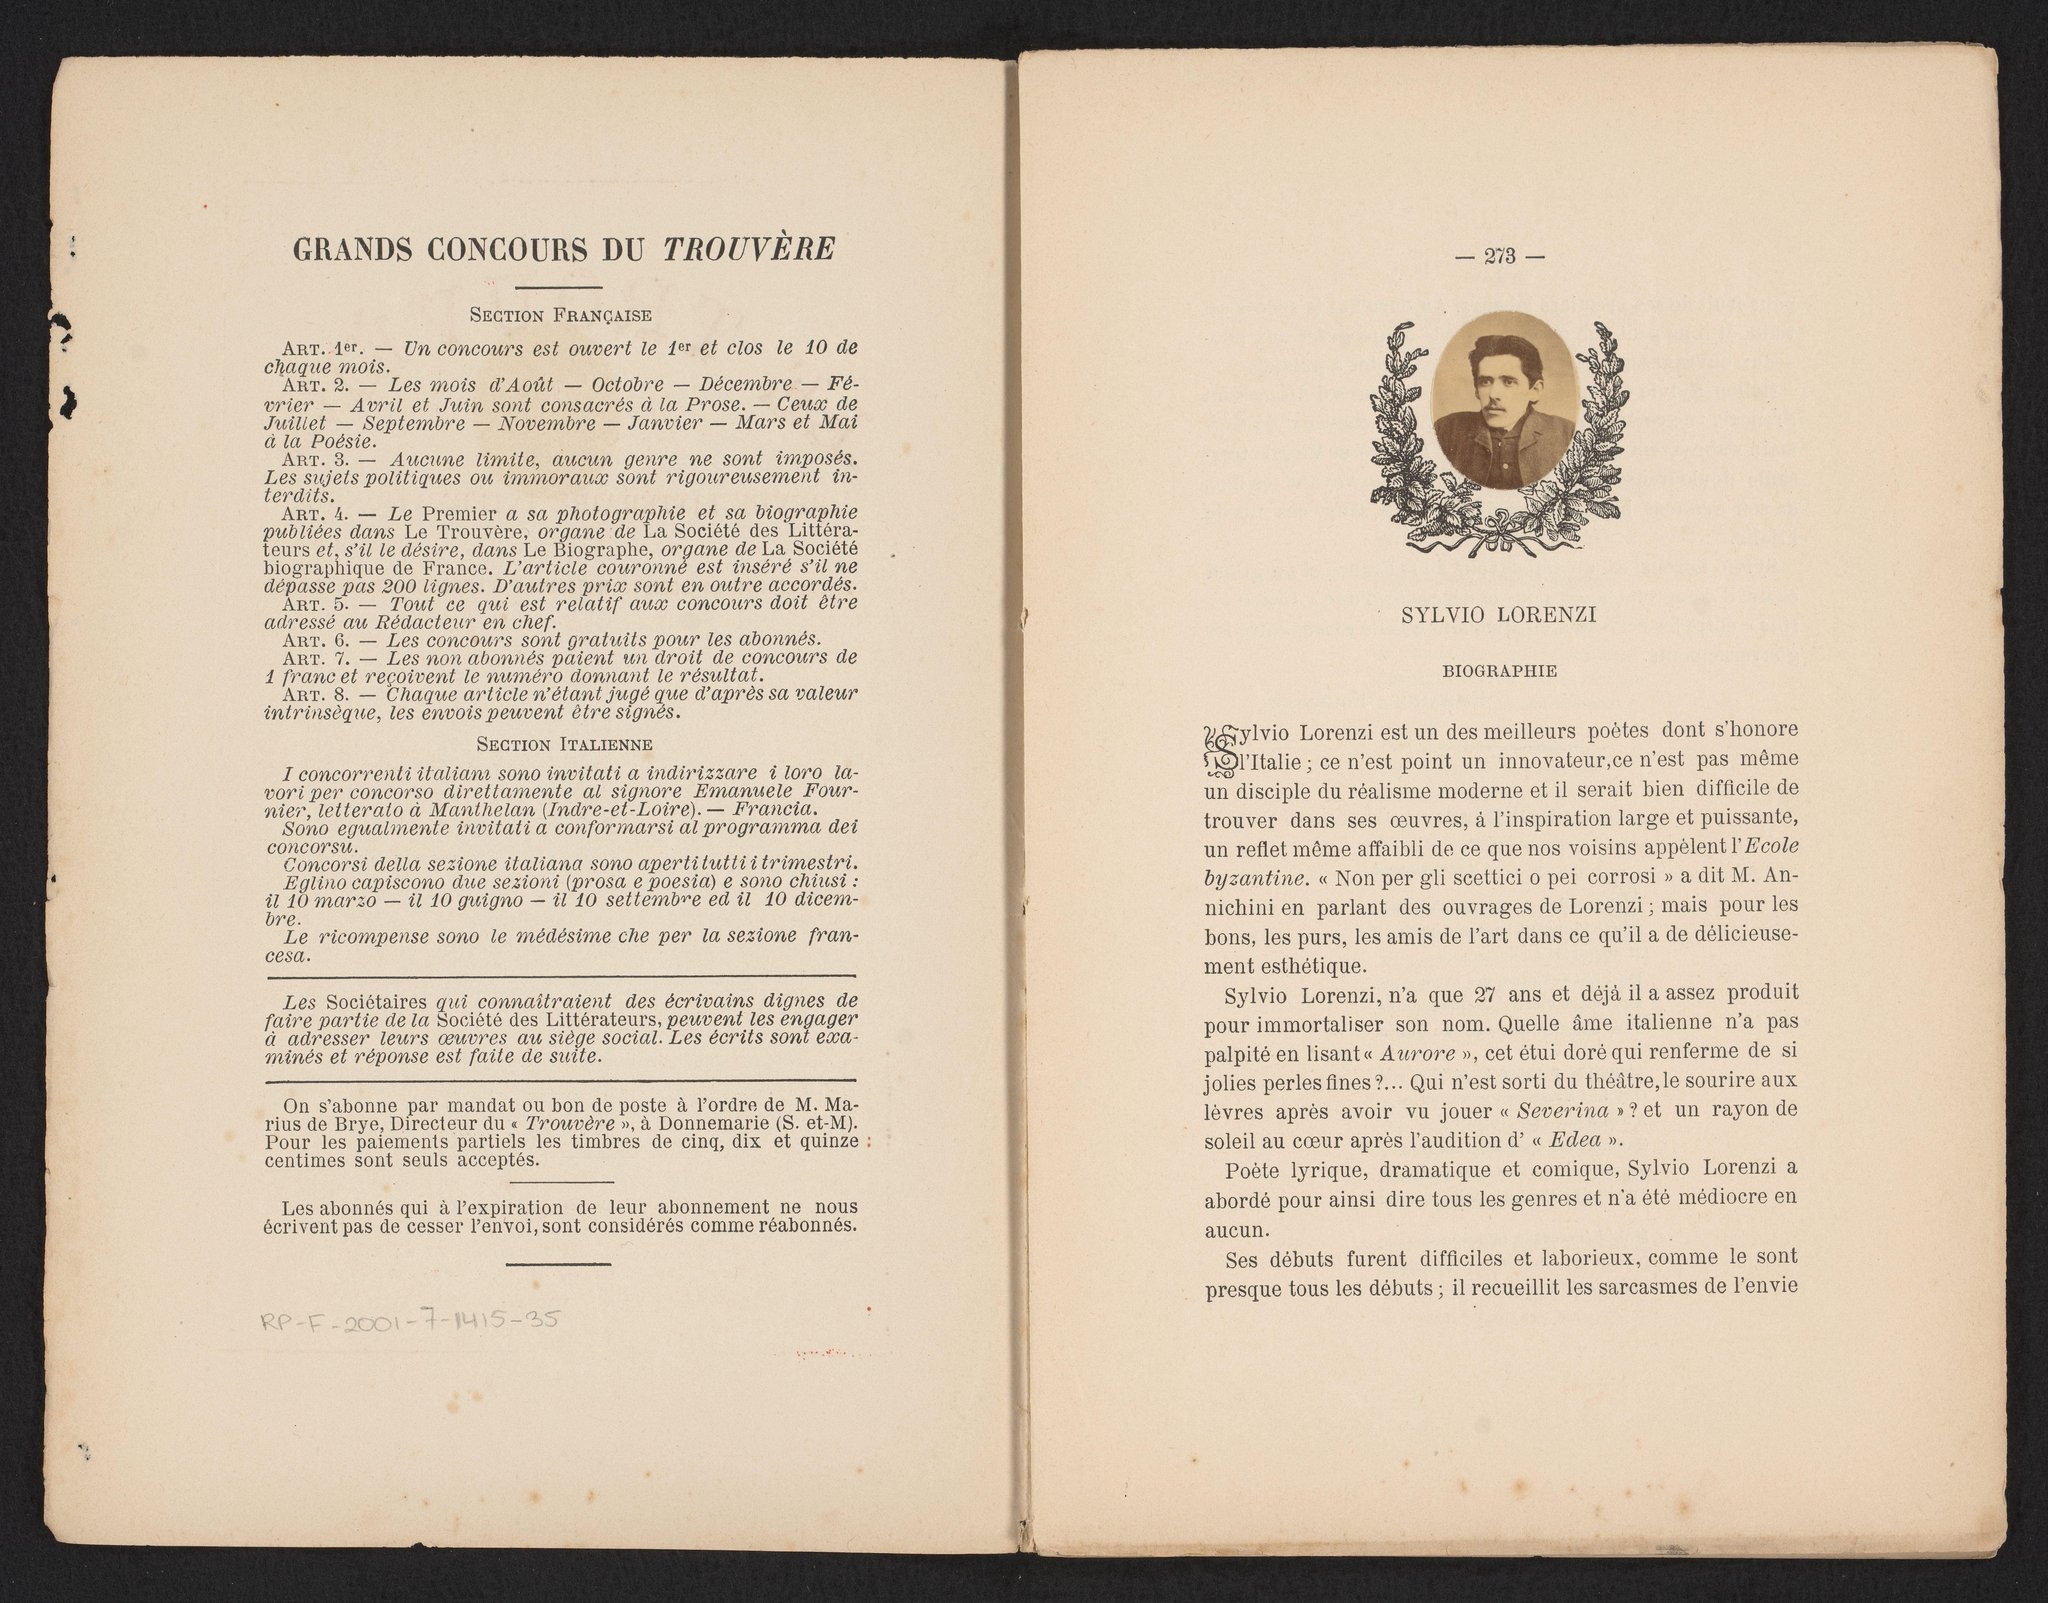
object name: page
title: Portret van Sylvio Lorenzi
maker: Anonymous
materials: photographic support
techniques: albumen print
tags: historical persons